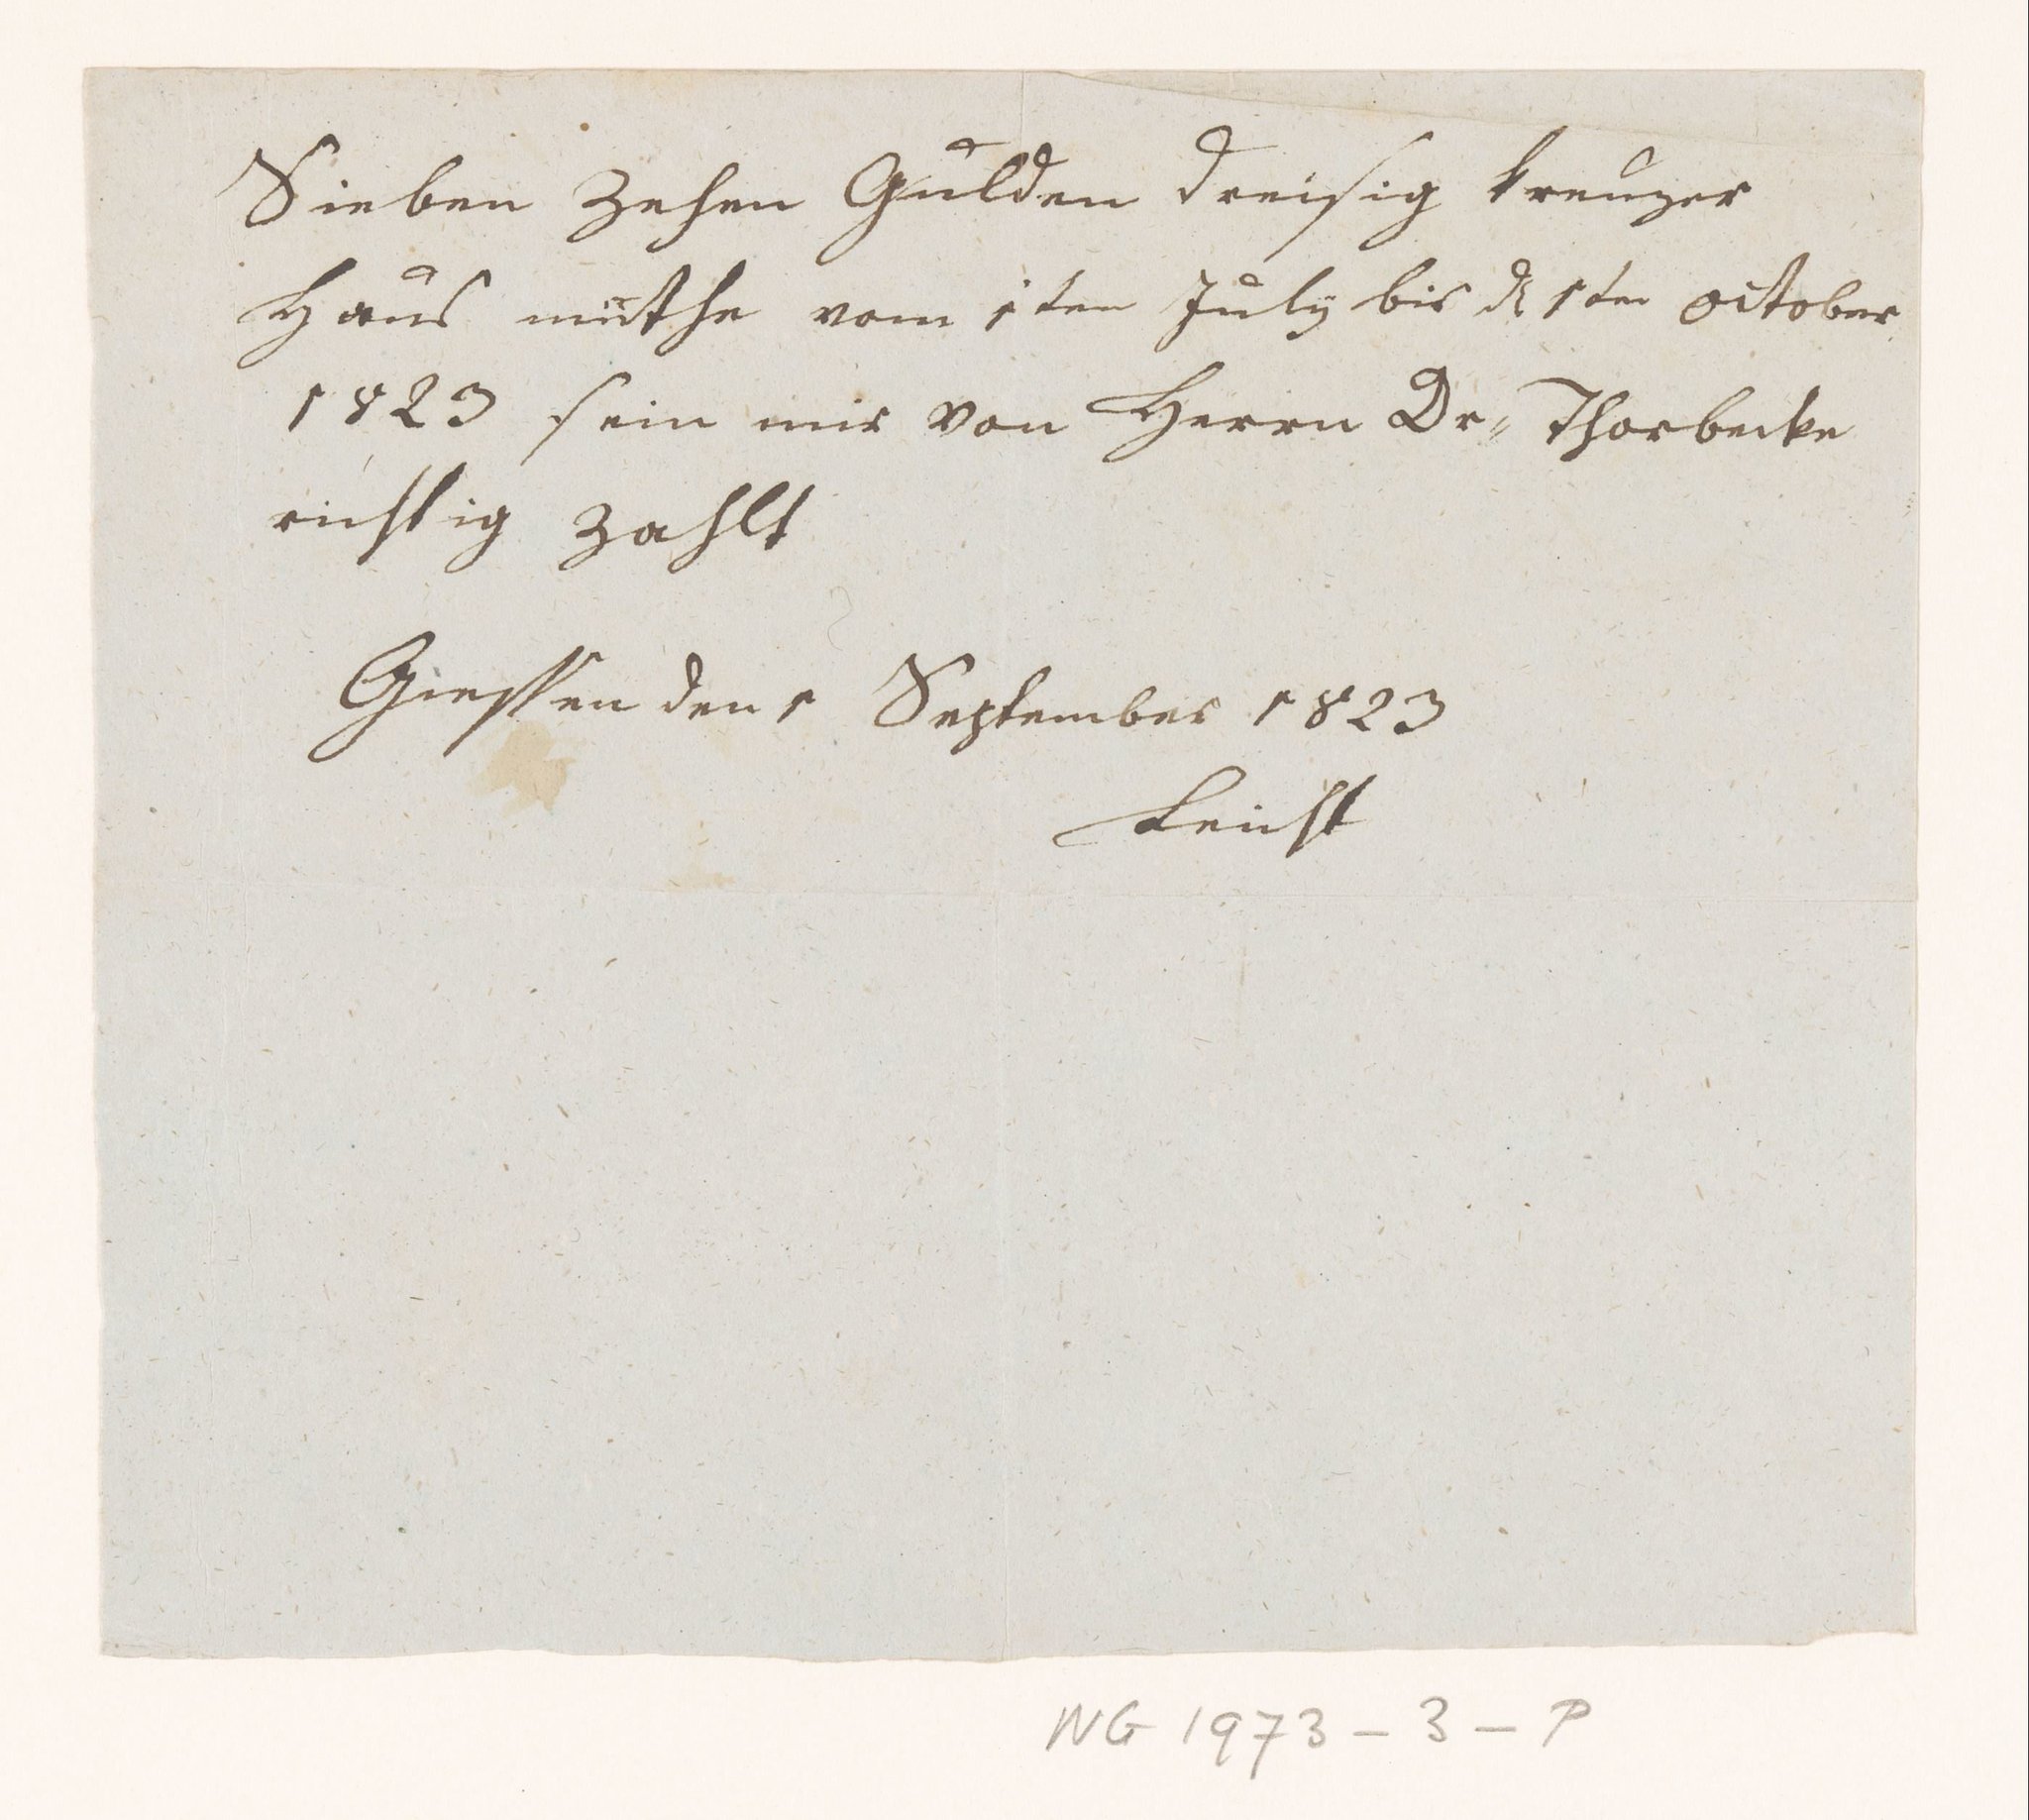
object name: ontvangstbewijs, kwitantie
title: Document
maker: Anonymous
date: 1823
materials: ink, paper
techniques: printing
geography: germany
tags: the hague, johan rudolf thorbecke, germany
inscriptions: date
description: Quitttantie Hausmitte Giessen. Gedateerd: 1 sept. 1823.